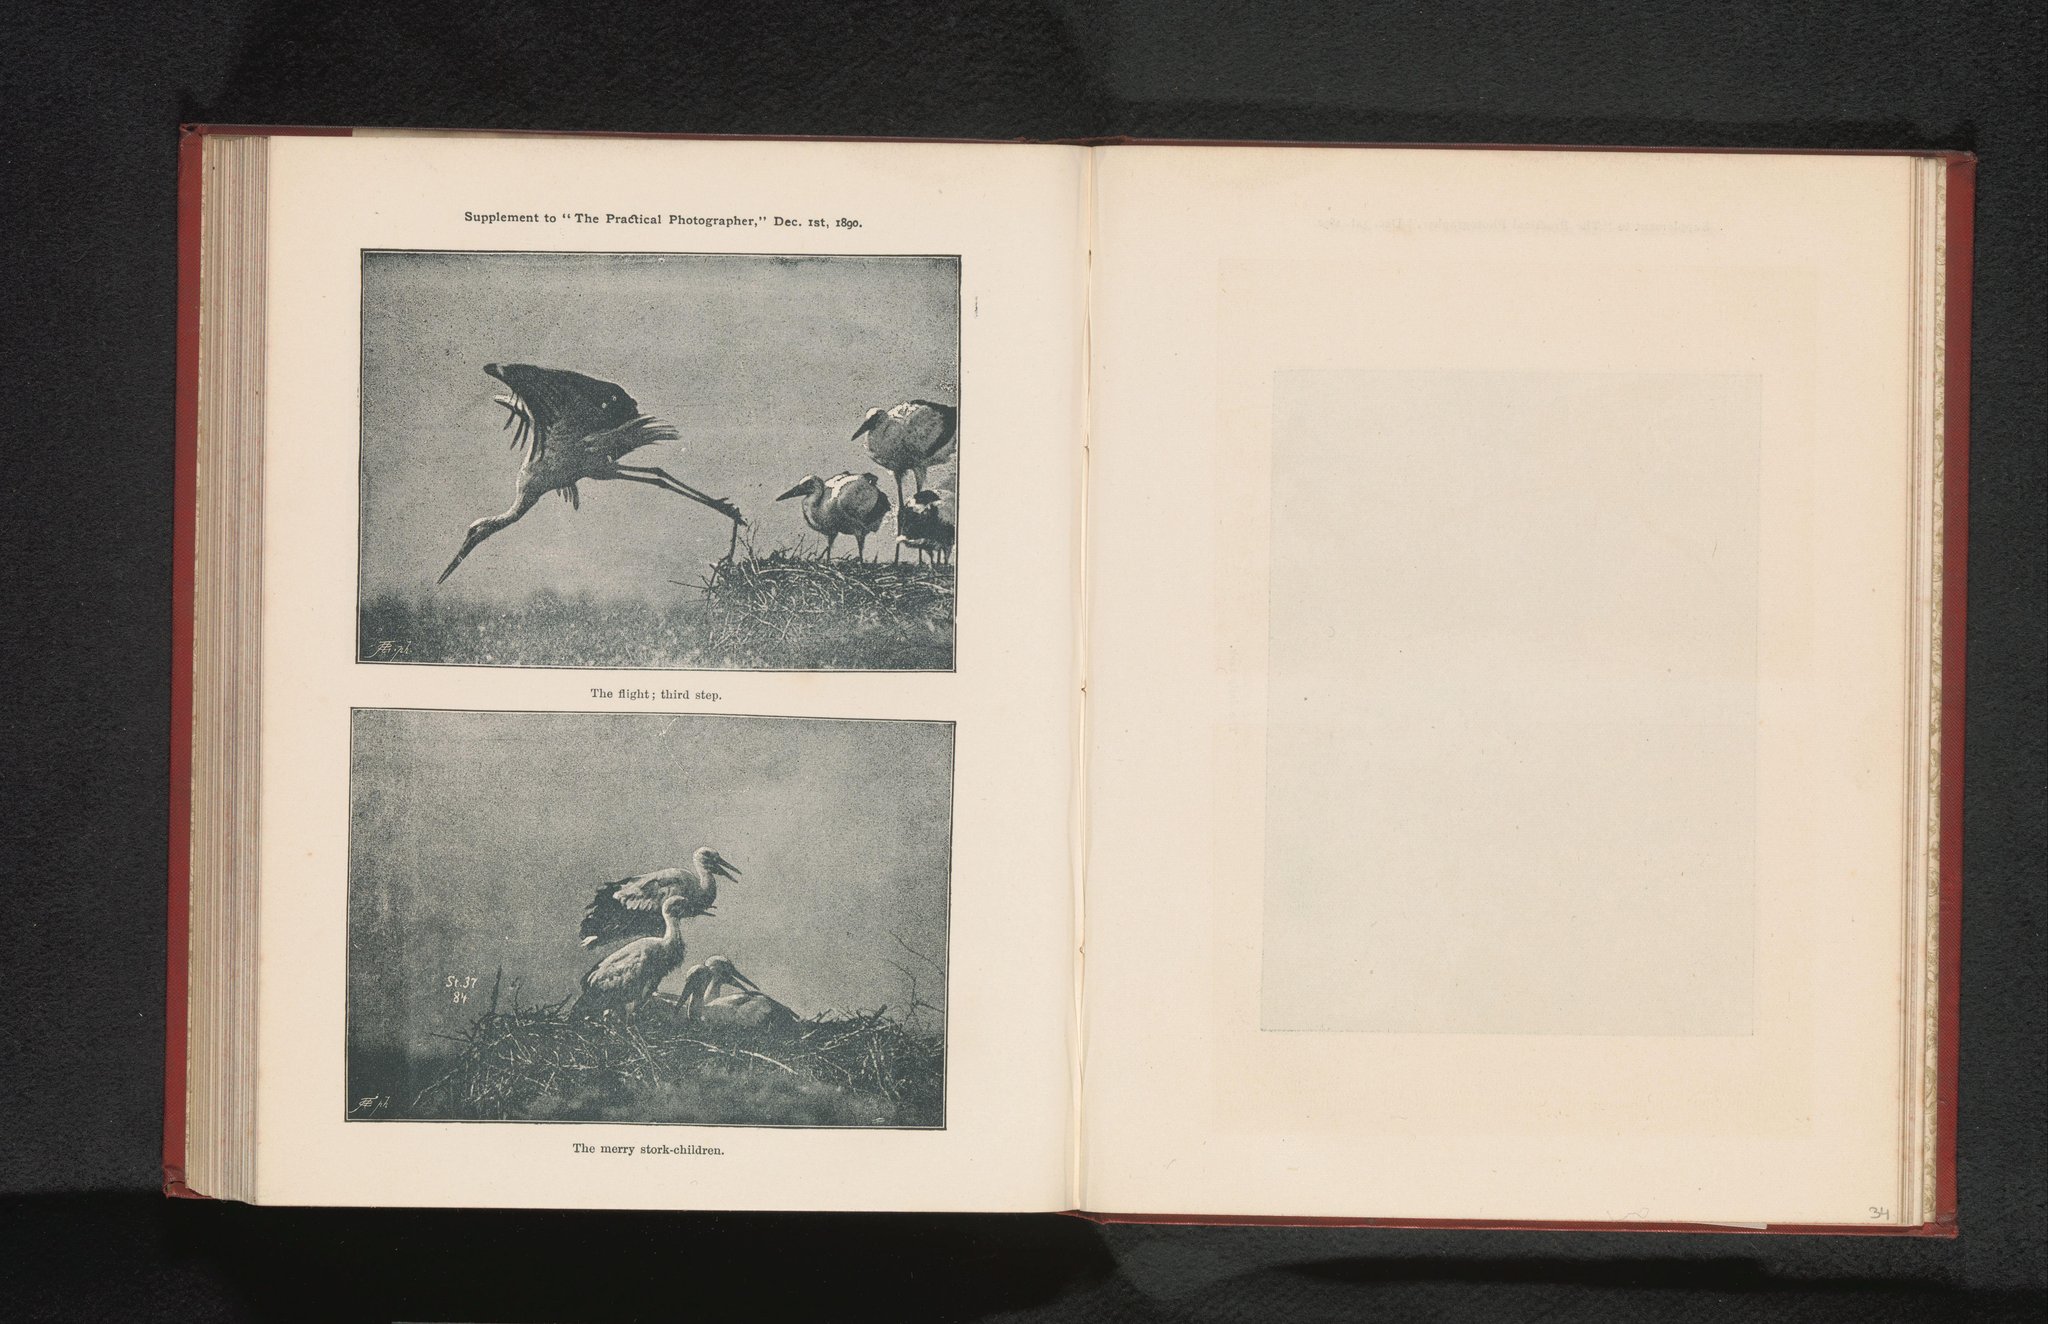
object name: page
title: The Flight ; Third Step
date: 1885-1890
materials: paper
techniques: autotype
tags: shore-birds and wading-birds: stork (+ nest, den, burrow), shore-birds and wading-birds: stork (+ animal(s) in motion; positions, expressions of animals)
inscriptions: number: ‘St. 37/ 84’, inscription: ‘Supplement to "The Practical Photographer," Dec. 1st, 1890.’, monogram: ‘AG ph.’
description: Prenten op vierde ongenummerde pagina na pagina 294.